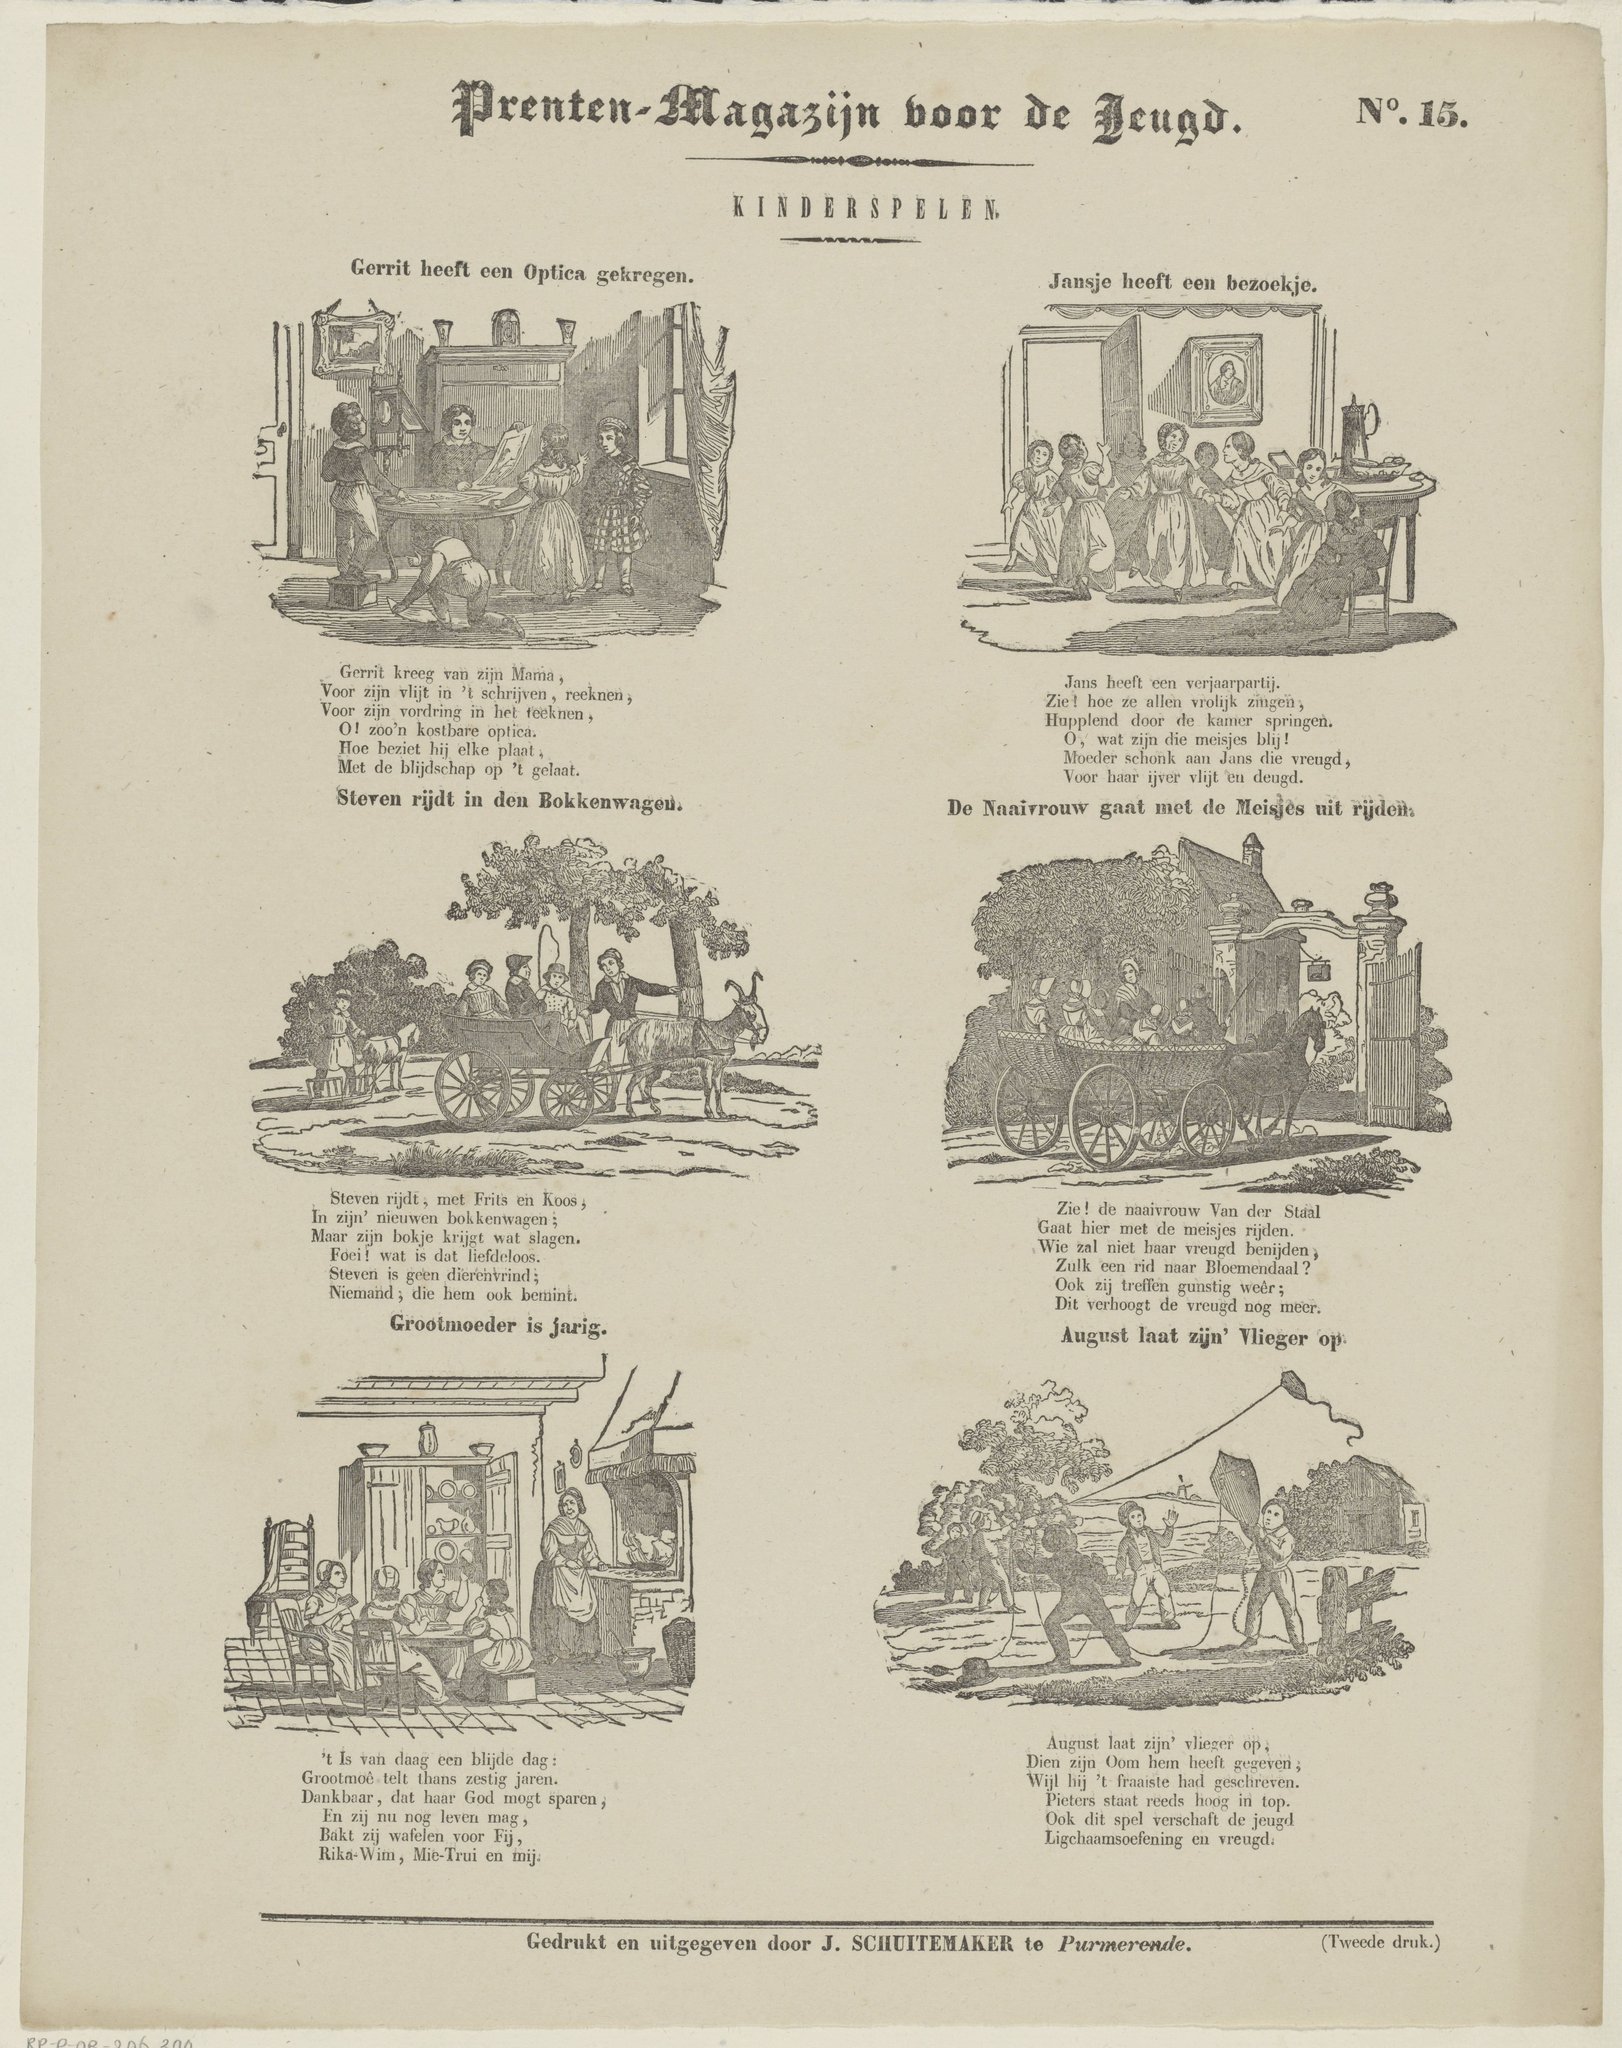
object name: popular print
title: Kinderspelen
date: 1842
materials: paper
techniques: letterpress printing, engraving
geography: netherlands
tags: children's games and plays, four-wheeled, animal-drawn vehicle, e.g.: cab, carriage, coach, (flying a) kite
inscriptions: collector's mark: Lugt 2760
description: Blad met 6 voorstellingen van kinderspelen en bezigheden, zoals spelen met opticaprenten, rijden in een wagen en vliegeren. Boven elke voorstelling een titel en onder elke voorstelling een zesregelig vers. Genummerd rechtsboven: No. 15.